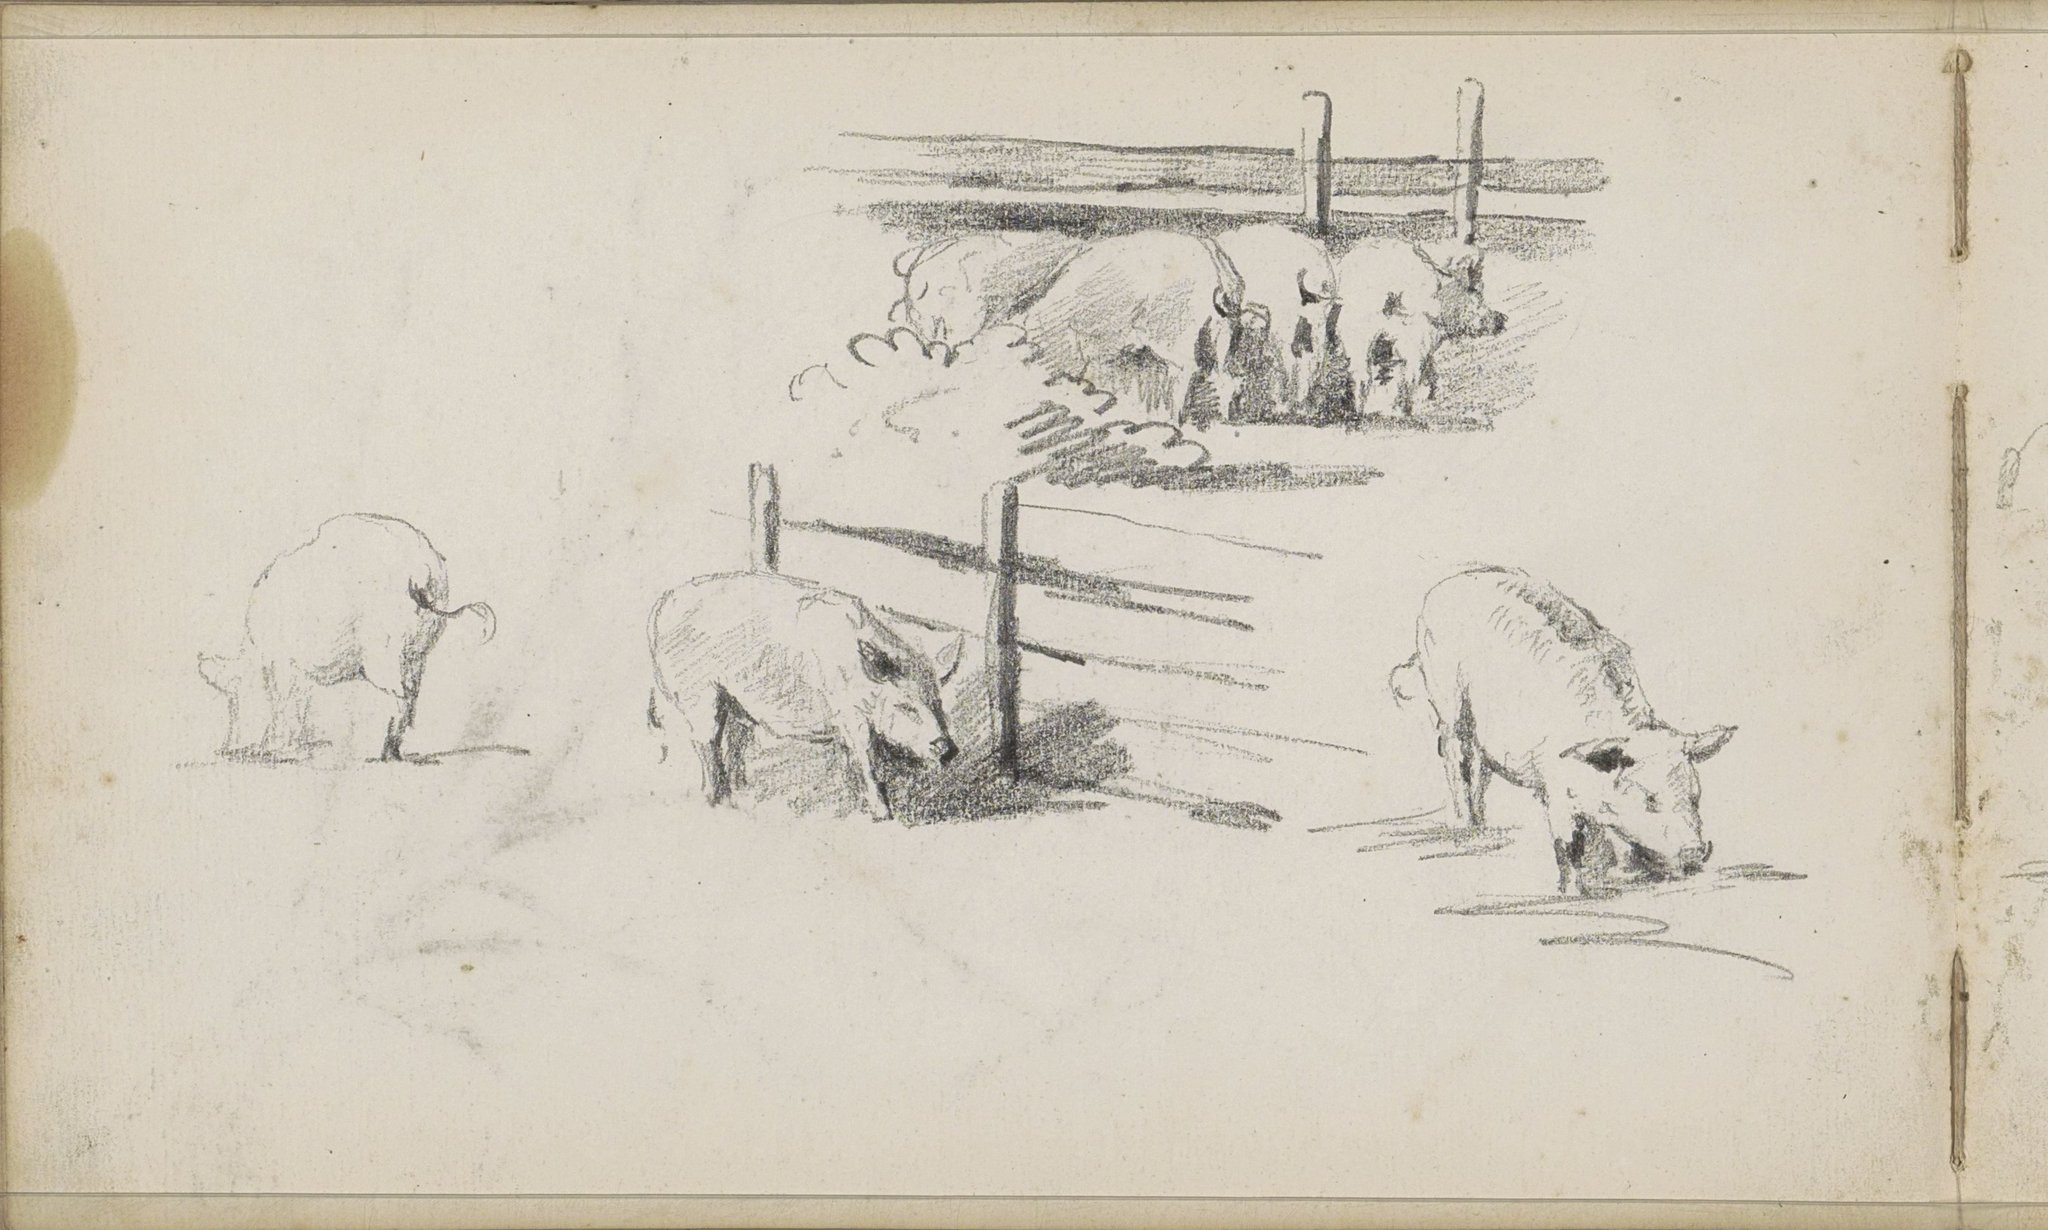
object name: sketchbook leaf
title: Varkens in een hok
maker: willem cornelis rip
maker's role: draughtsman, painter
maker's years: 1856-1922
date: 1876-1877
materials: paper, pencil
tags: pig, fence, wall, paling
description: Blad 25 verso uit een schetsboek met 41 bladen.